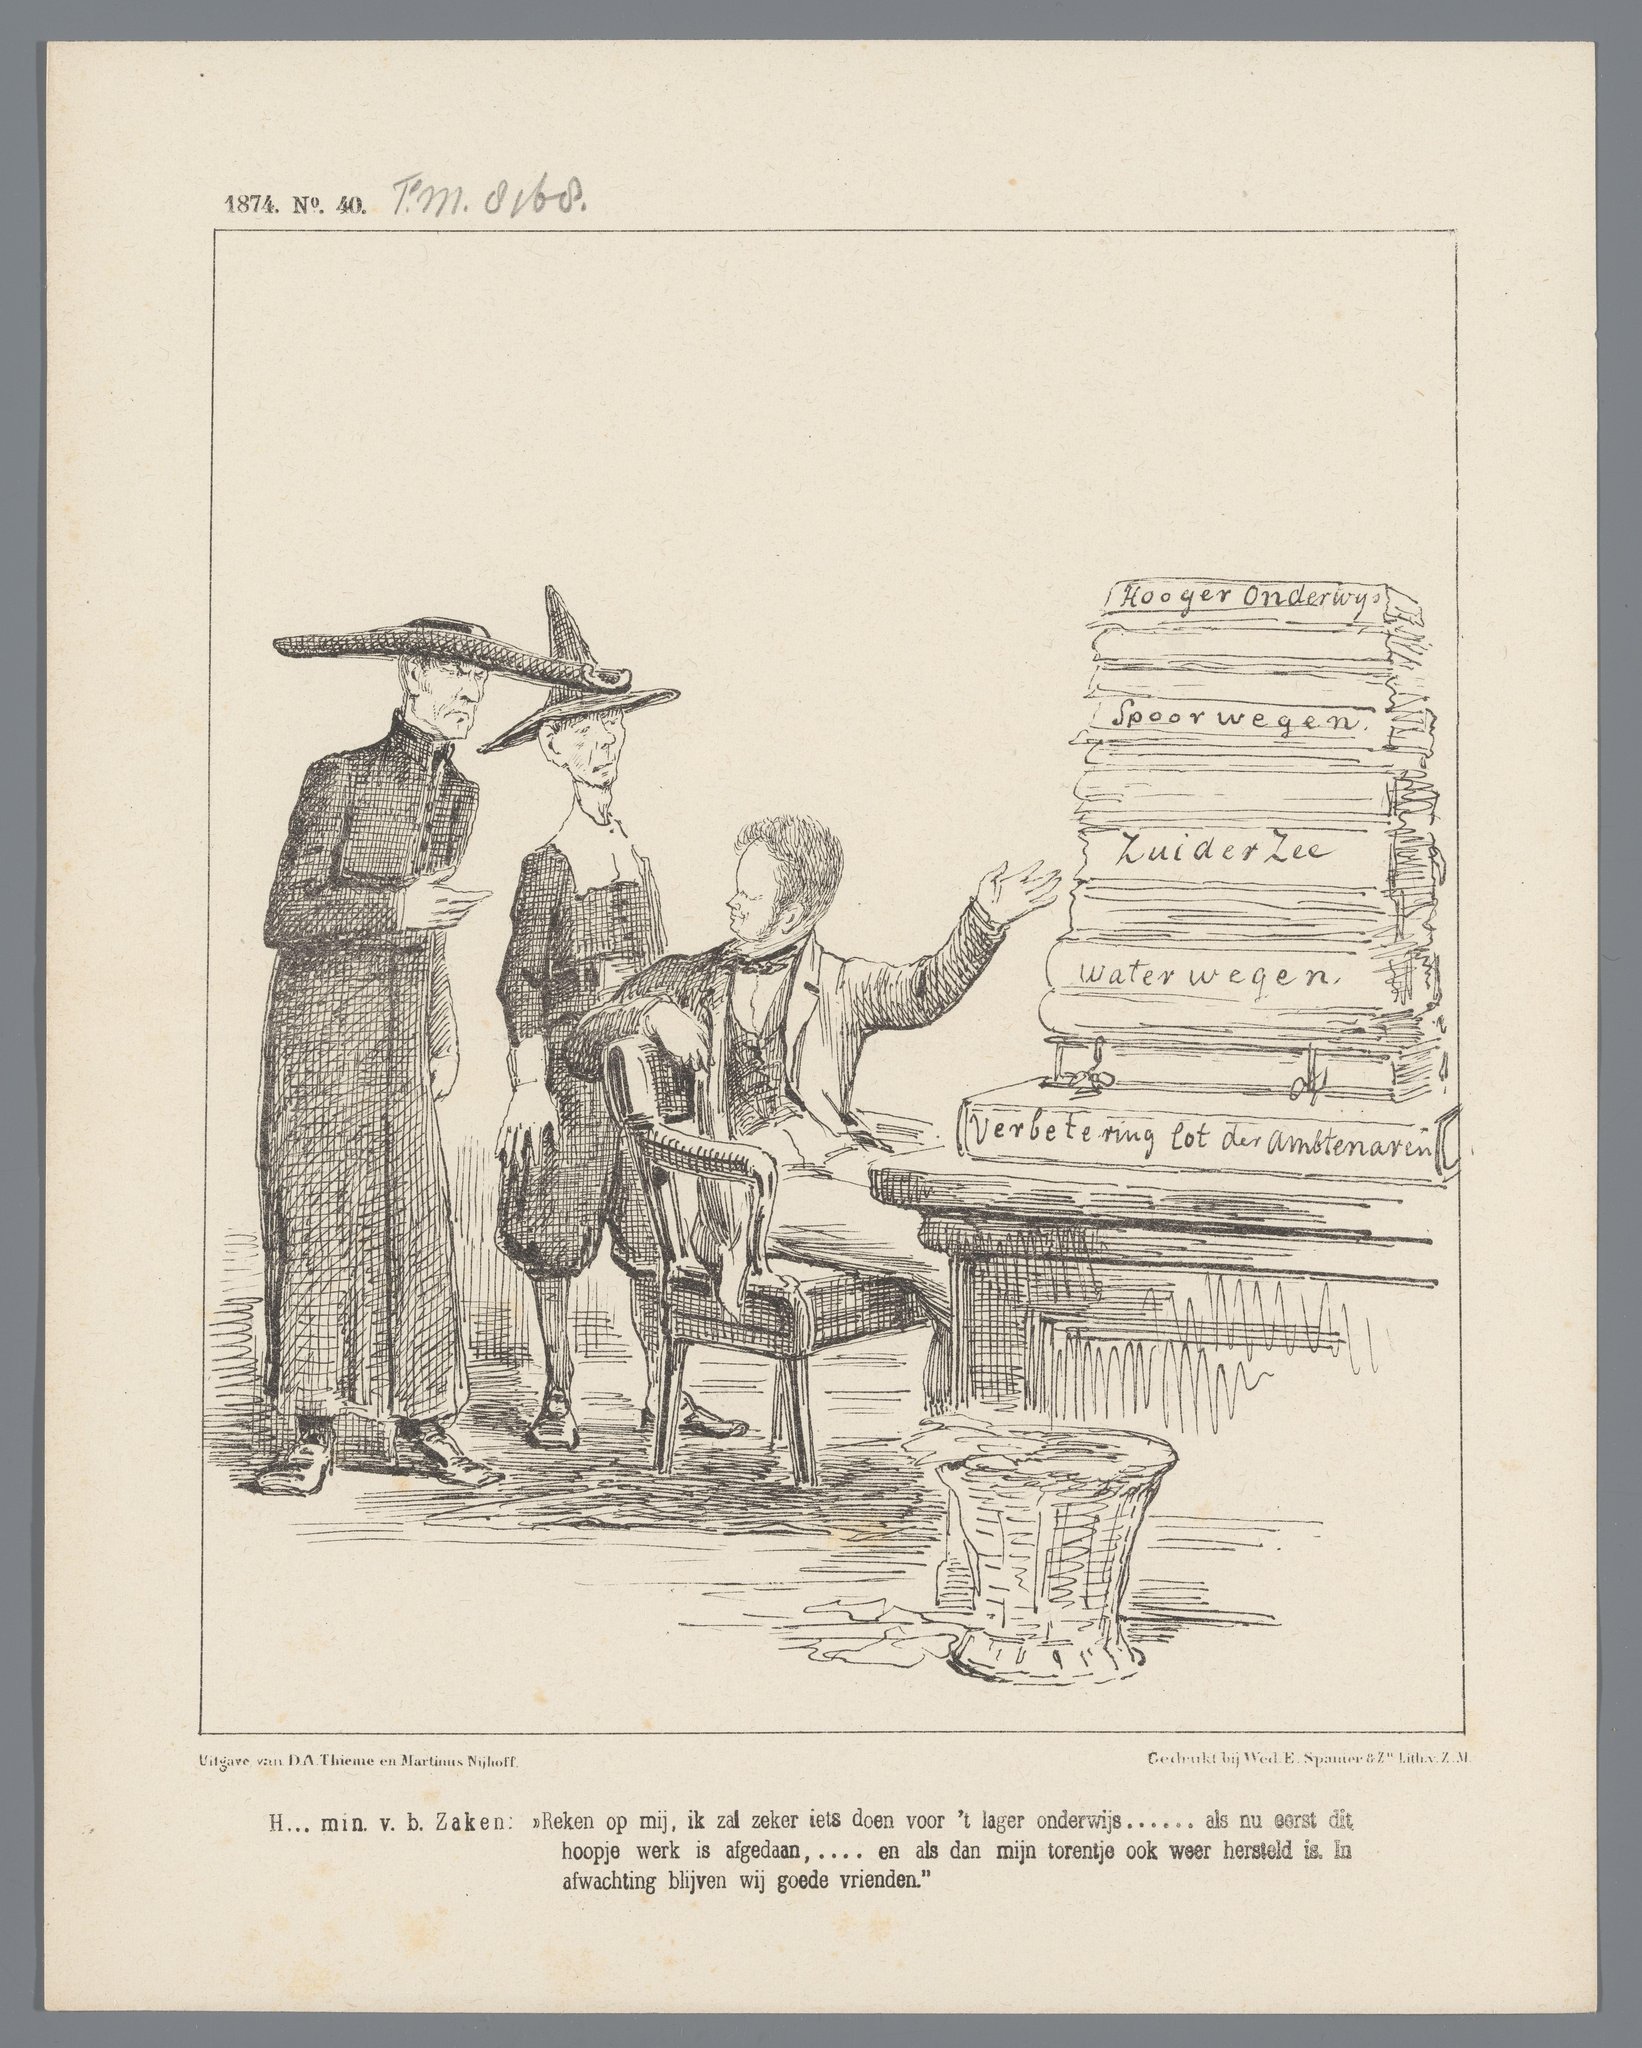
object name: print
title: Spotprent met minister Heemskerk en het vele werk dat nog op zijn bureau ligt, 1874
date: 1874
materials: paper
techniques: lithograph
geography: netherlands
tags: amsterdam, politician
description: Spotprent met minister Heemskerk die wijst op het vele werk dat nog op zijn bureau ligt, en daarom nog geen tijd heeft voor een wijziging van de wet op lager onderwijs, 1874. Plaat verschenen bij het weekblad De Nederlandsche Spectator, nr. 40, 1874.